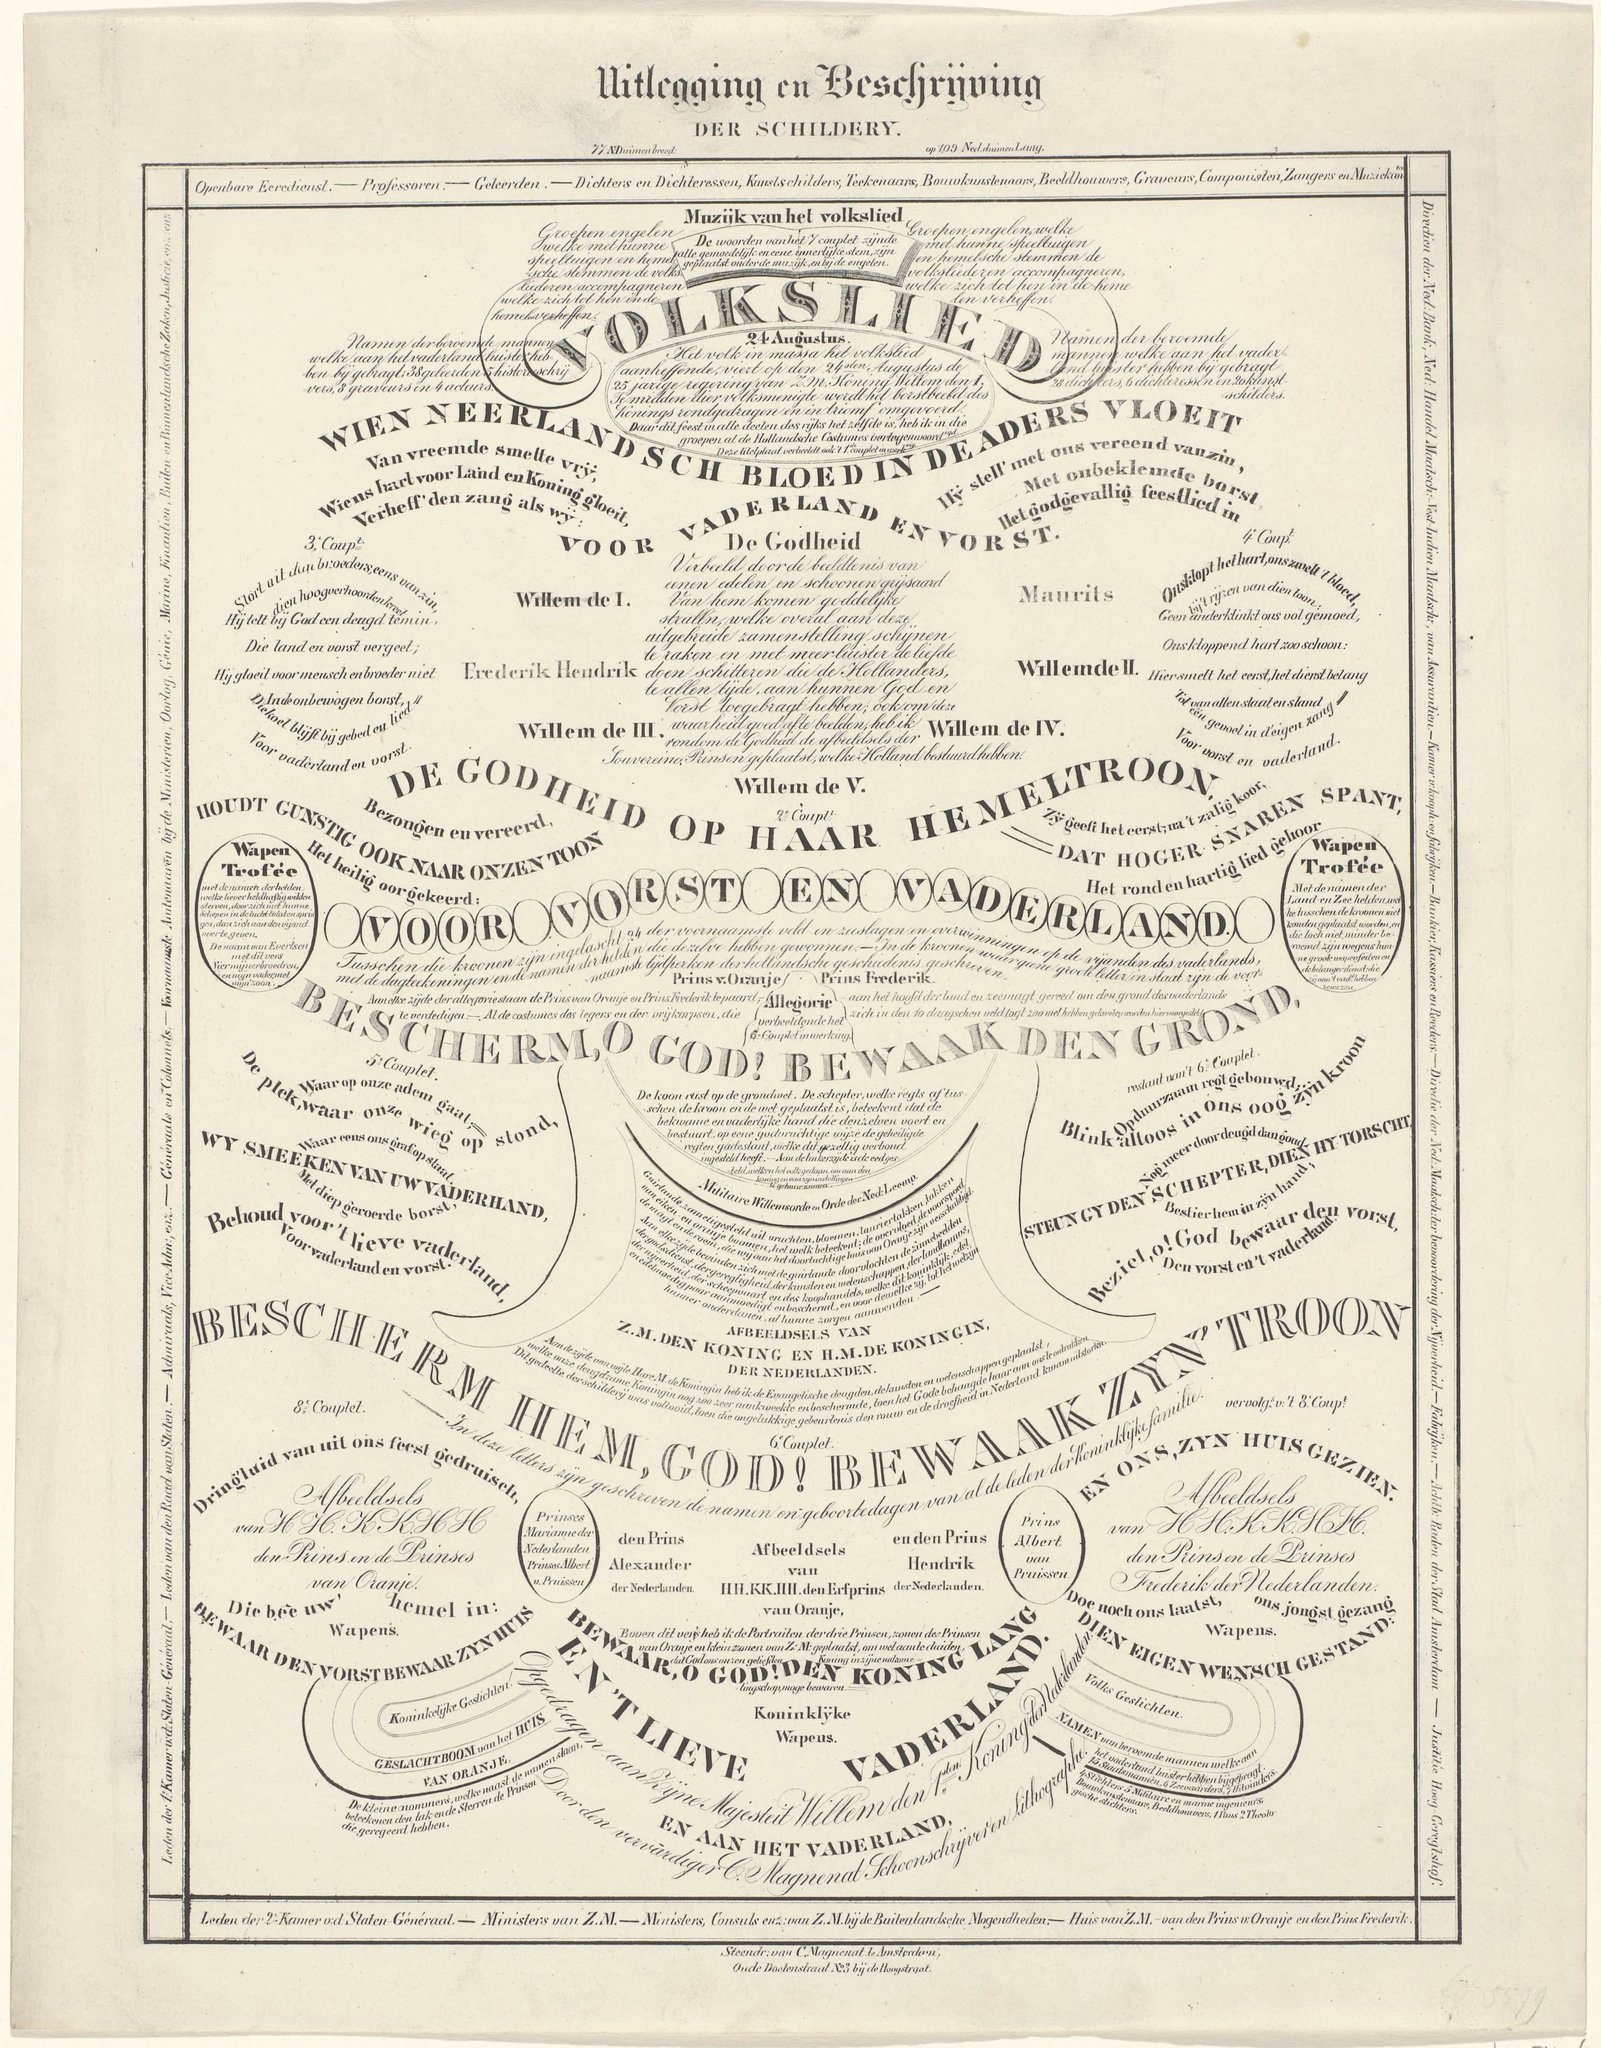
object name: print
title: Uitlegging en Beschrijving der Schildery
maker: willem charles magnenat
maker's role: print maker, printer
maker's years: 1803-1871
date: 1838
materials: paper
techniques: lithograph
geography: amsterdam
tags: the hague, berlin, william i of the netherlands, calligraphy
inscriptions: collector's mark: Lugt 2228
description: Verklaring van de kalligrafische voorstelling op het vijfentwintigjarige regeringsjubileum van koning Willem I in november 1838 met de coupletten van het lied 'Wien Neêrlands Bloed in de Aders vloeit' uitgevoerd in kalligrafie.